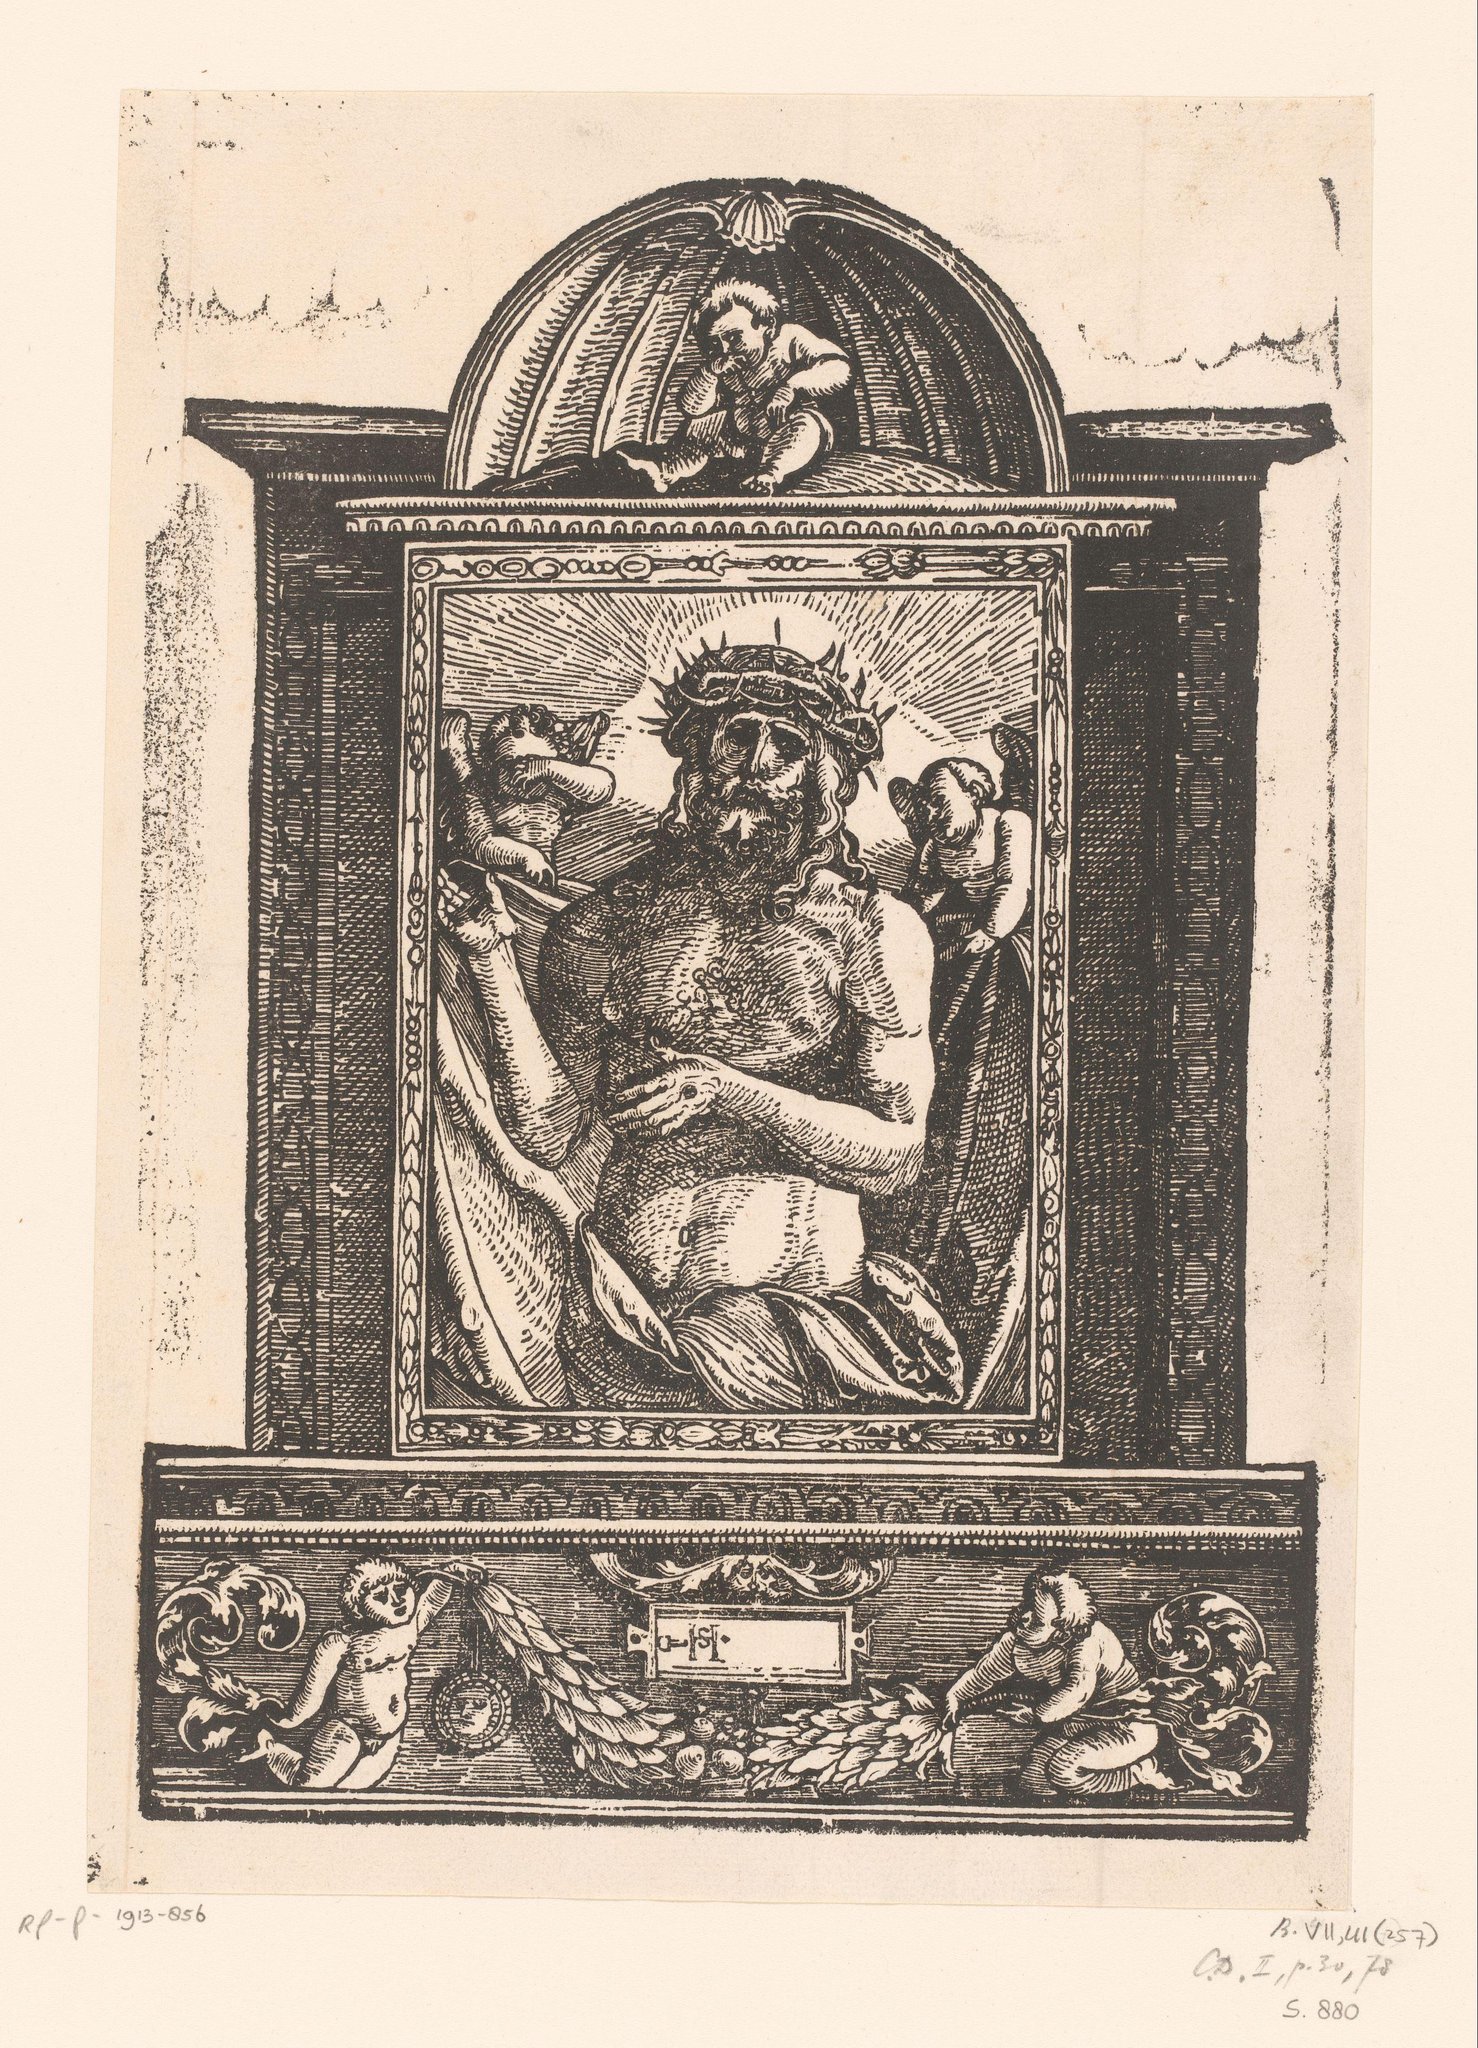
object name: print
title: Man van Smarten in een ornamentele omlijsting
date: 1520-1526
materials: paper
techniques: woodcut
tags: man of sorrows, 'imago pietatis', 'erbärmdebild', 'schmerzensmann'; the upright christ showing his wounds, usually bearing the crown of thorns, and accompanied by the instruments of the passion, standing or sitting in his tomb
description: Prent voor het eerst gebruikt in: Speculum Passionis. Neurenberg: Ulrich Pinder, 1507.